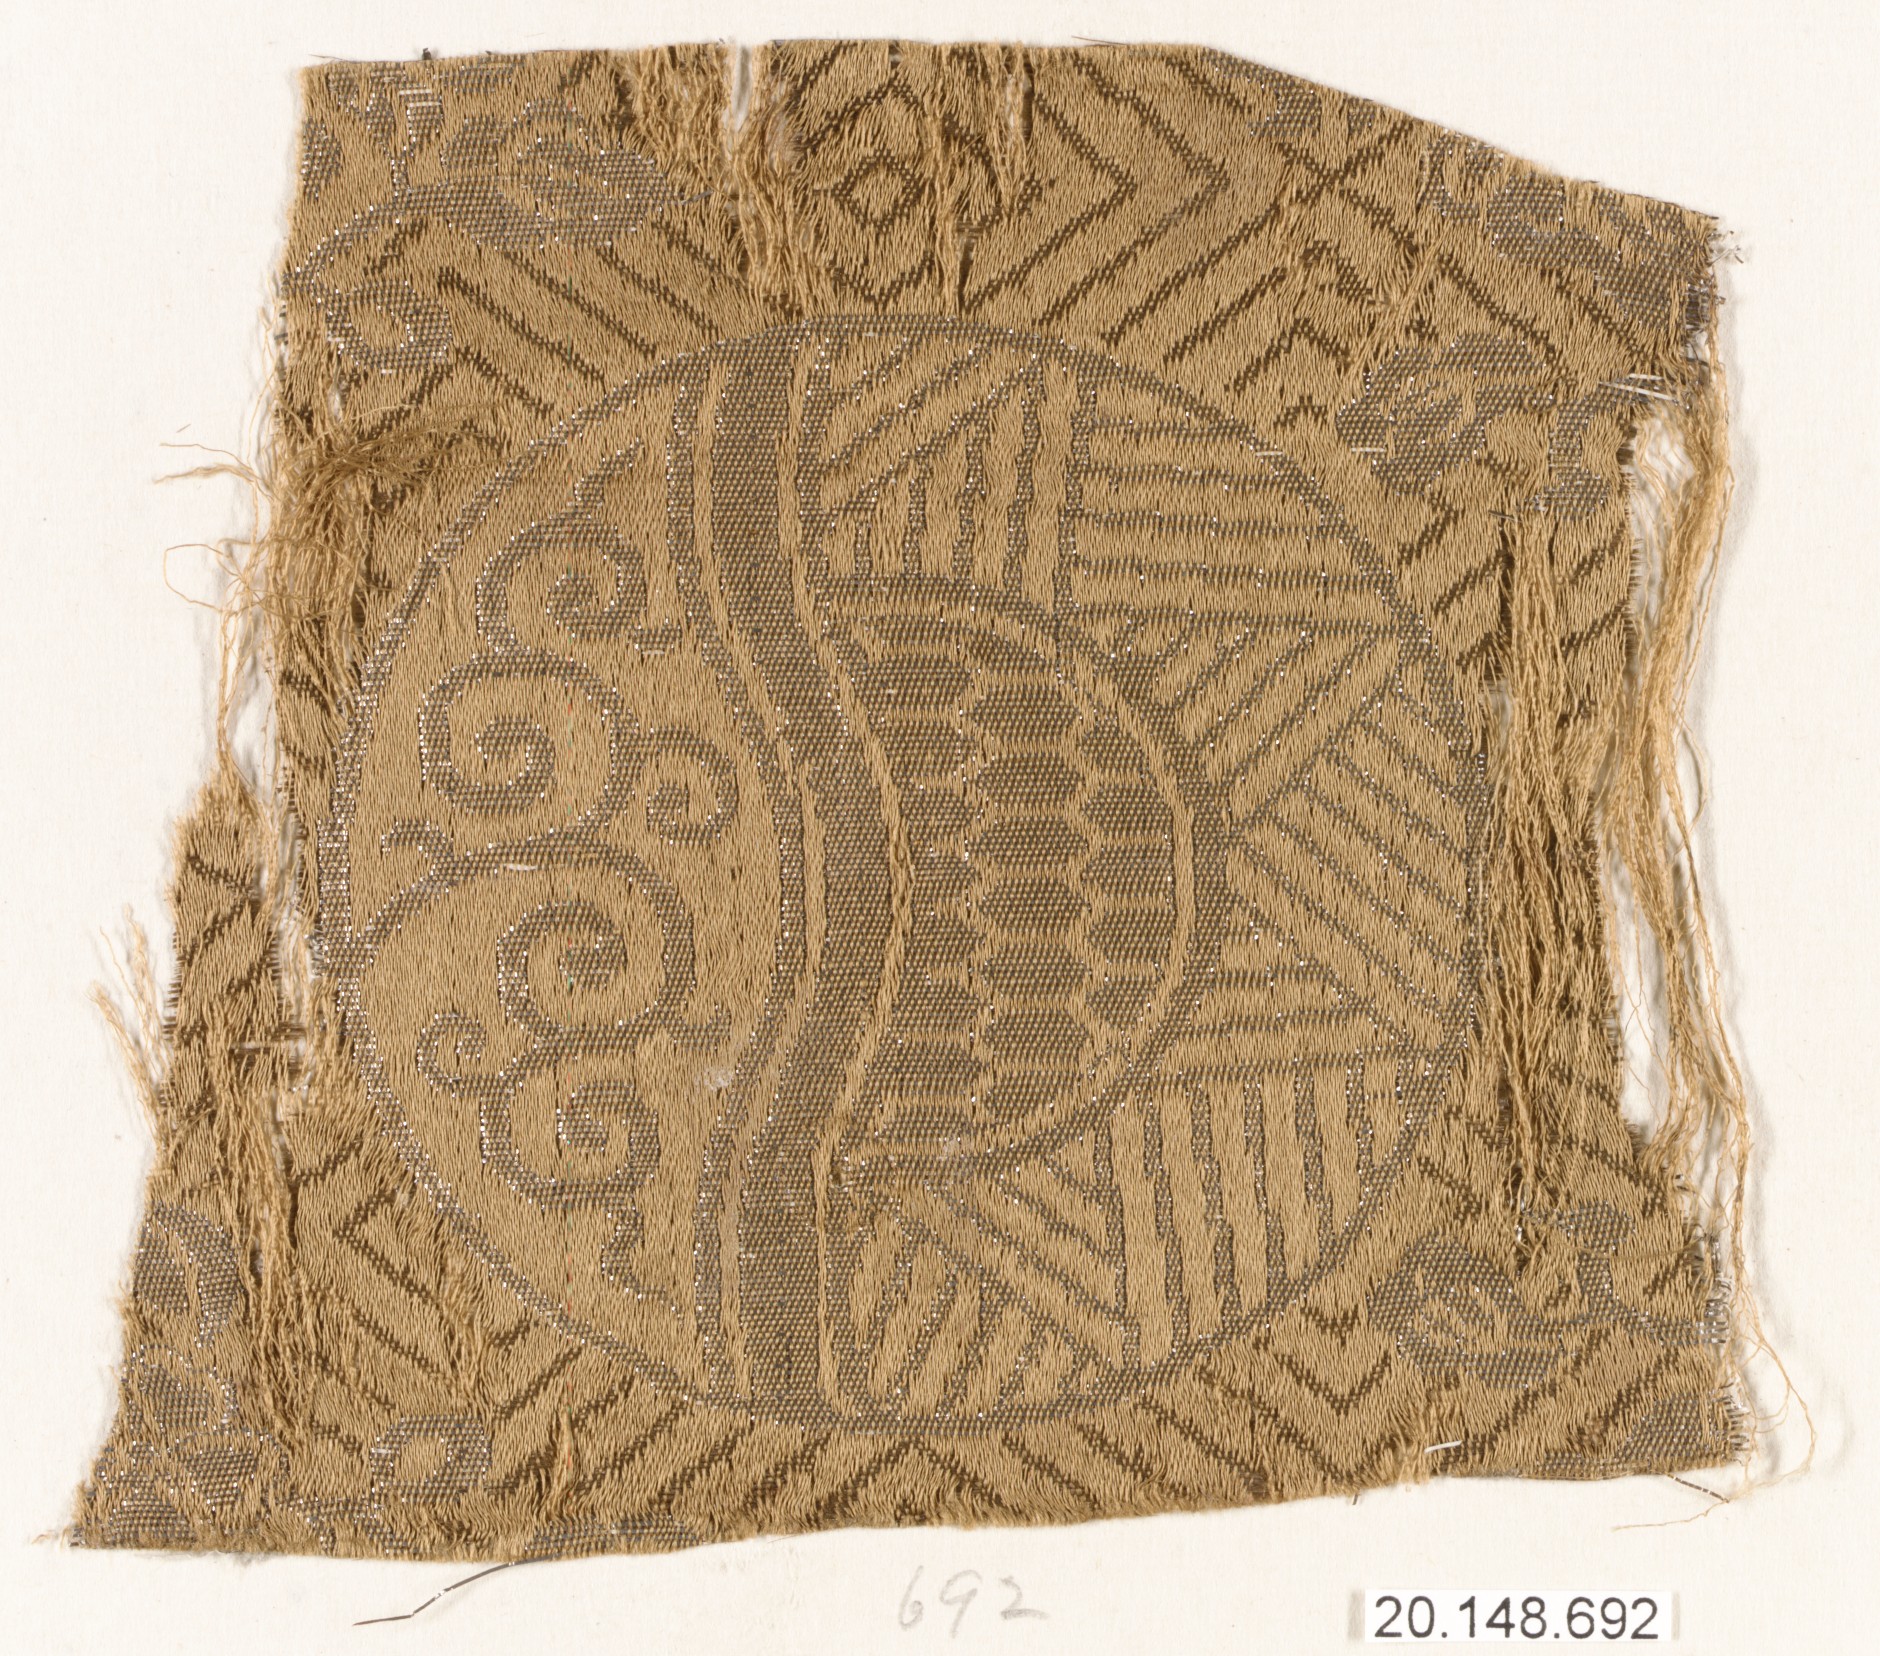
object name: piece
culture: china or japan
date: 1701-1800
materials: silk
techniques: compound weave